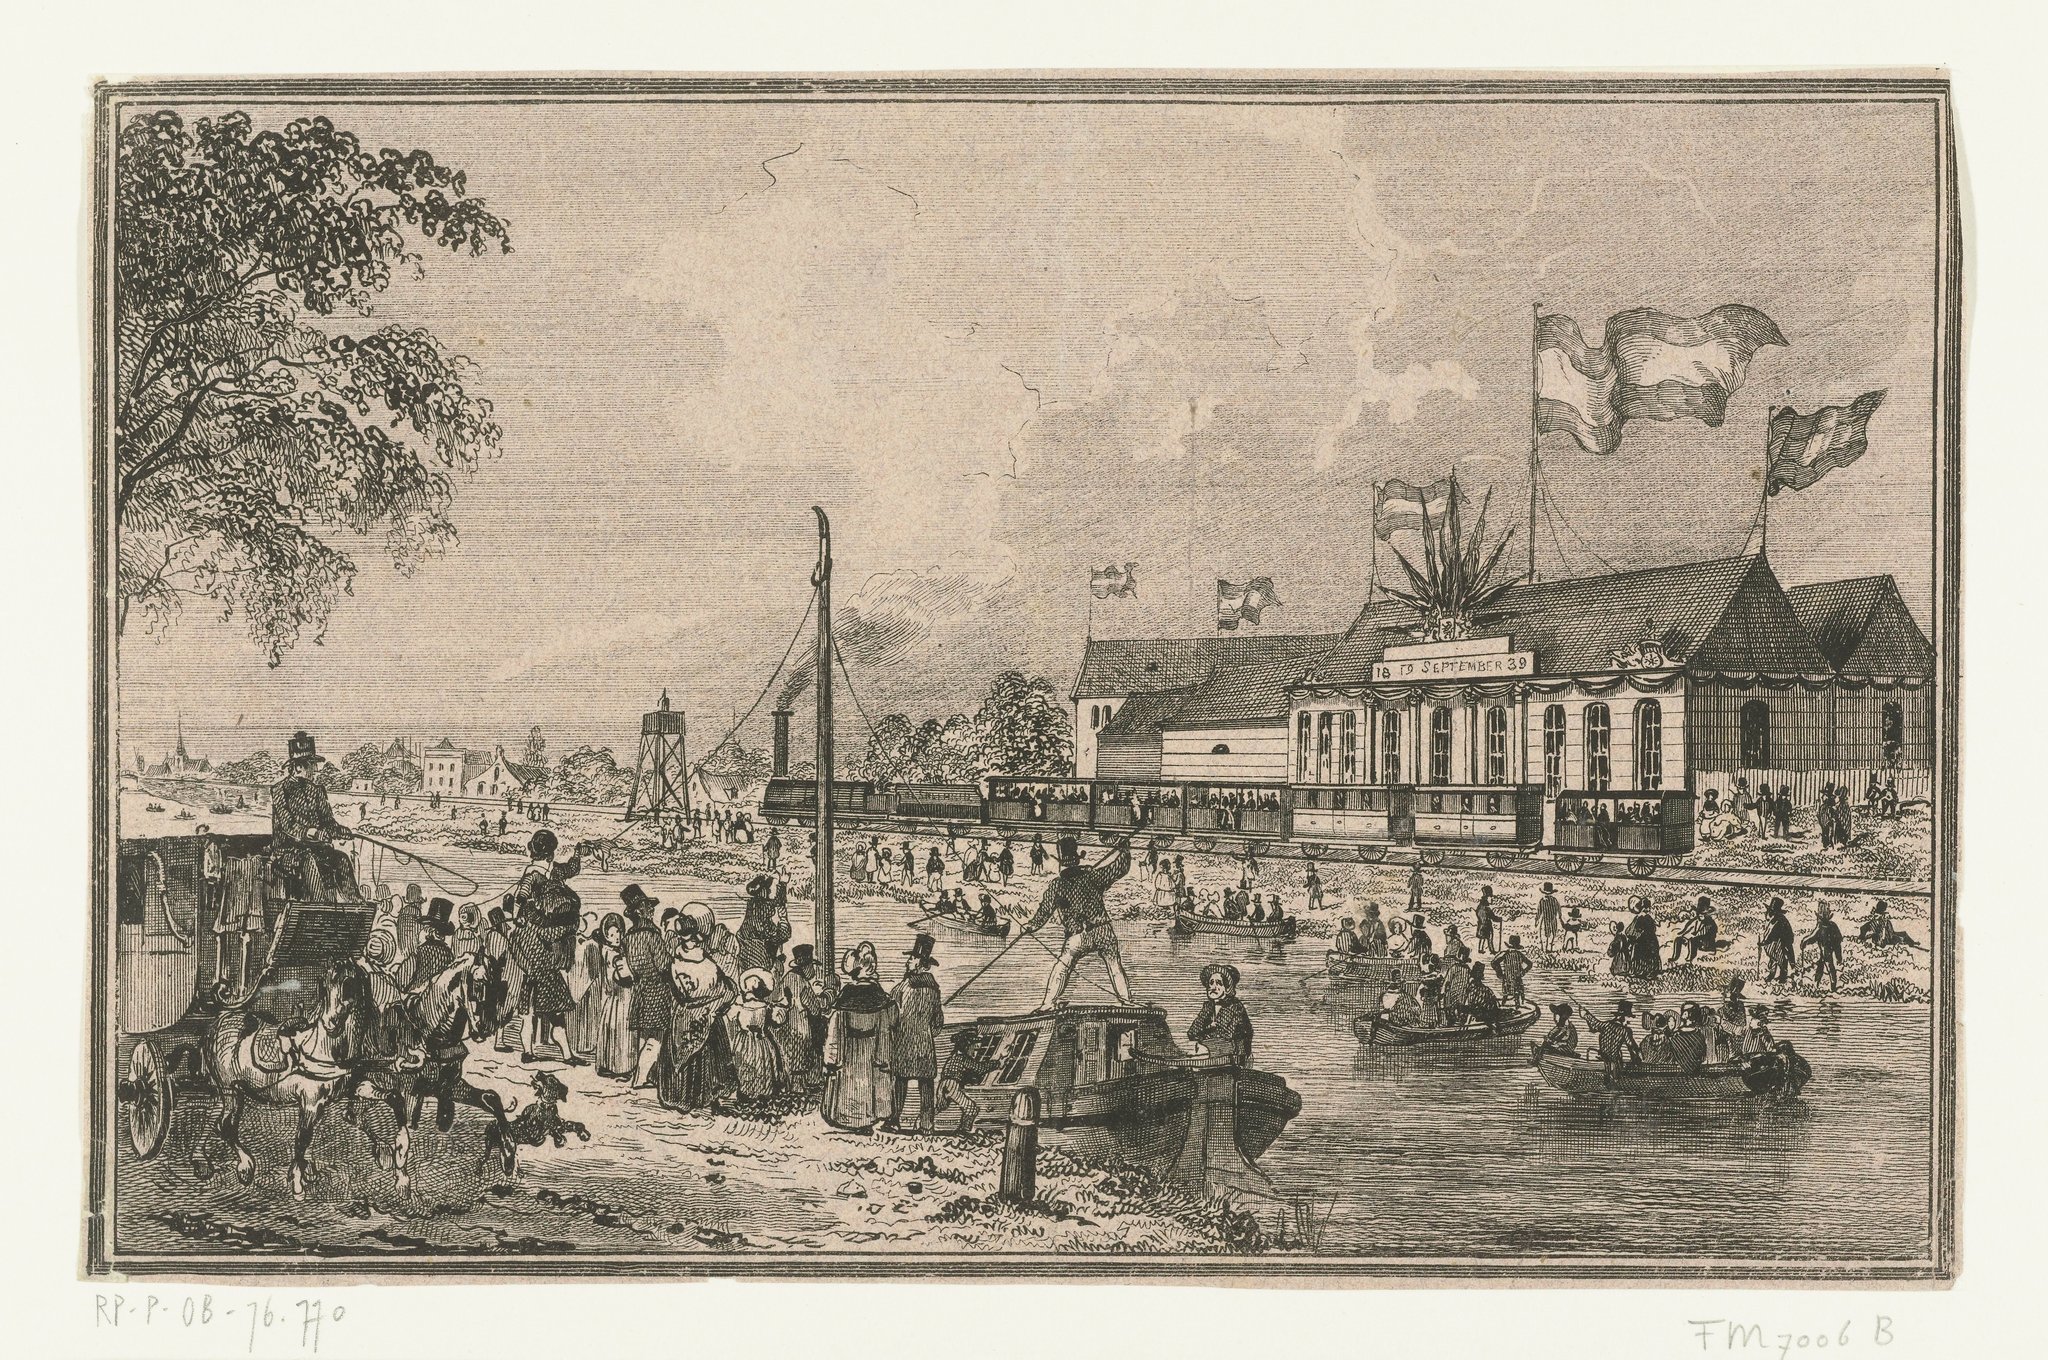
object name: print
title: Inwijding van de spoorweg tussen Amsterdam en Haarlem, 19 september 1839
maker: Anonymous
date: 1839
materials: paper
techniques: etching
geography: netherlands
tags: passenger train, festivities on events of national importance, steam locomotive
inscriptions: collector's mark: Lugt 2228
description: Feestelijke inwijding van de eerste Nederlandse spoorlijn tussen Amsterdam en Haarlem van de Hollandsche IJzeren Spoorweg-Maatschappij op 19 september 1839. De locomotief gemerkt 'De Snelheid' met zes passagierwagons voor het station d'Eenhonderd Roe, in het midden de Haarlemmertrekvaart, op de voorgrond links toeschouwers.